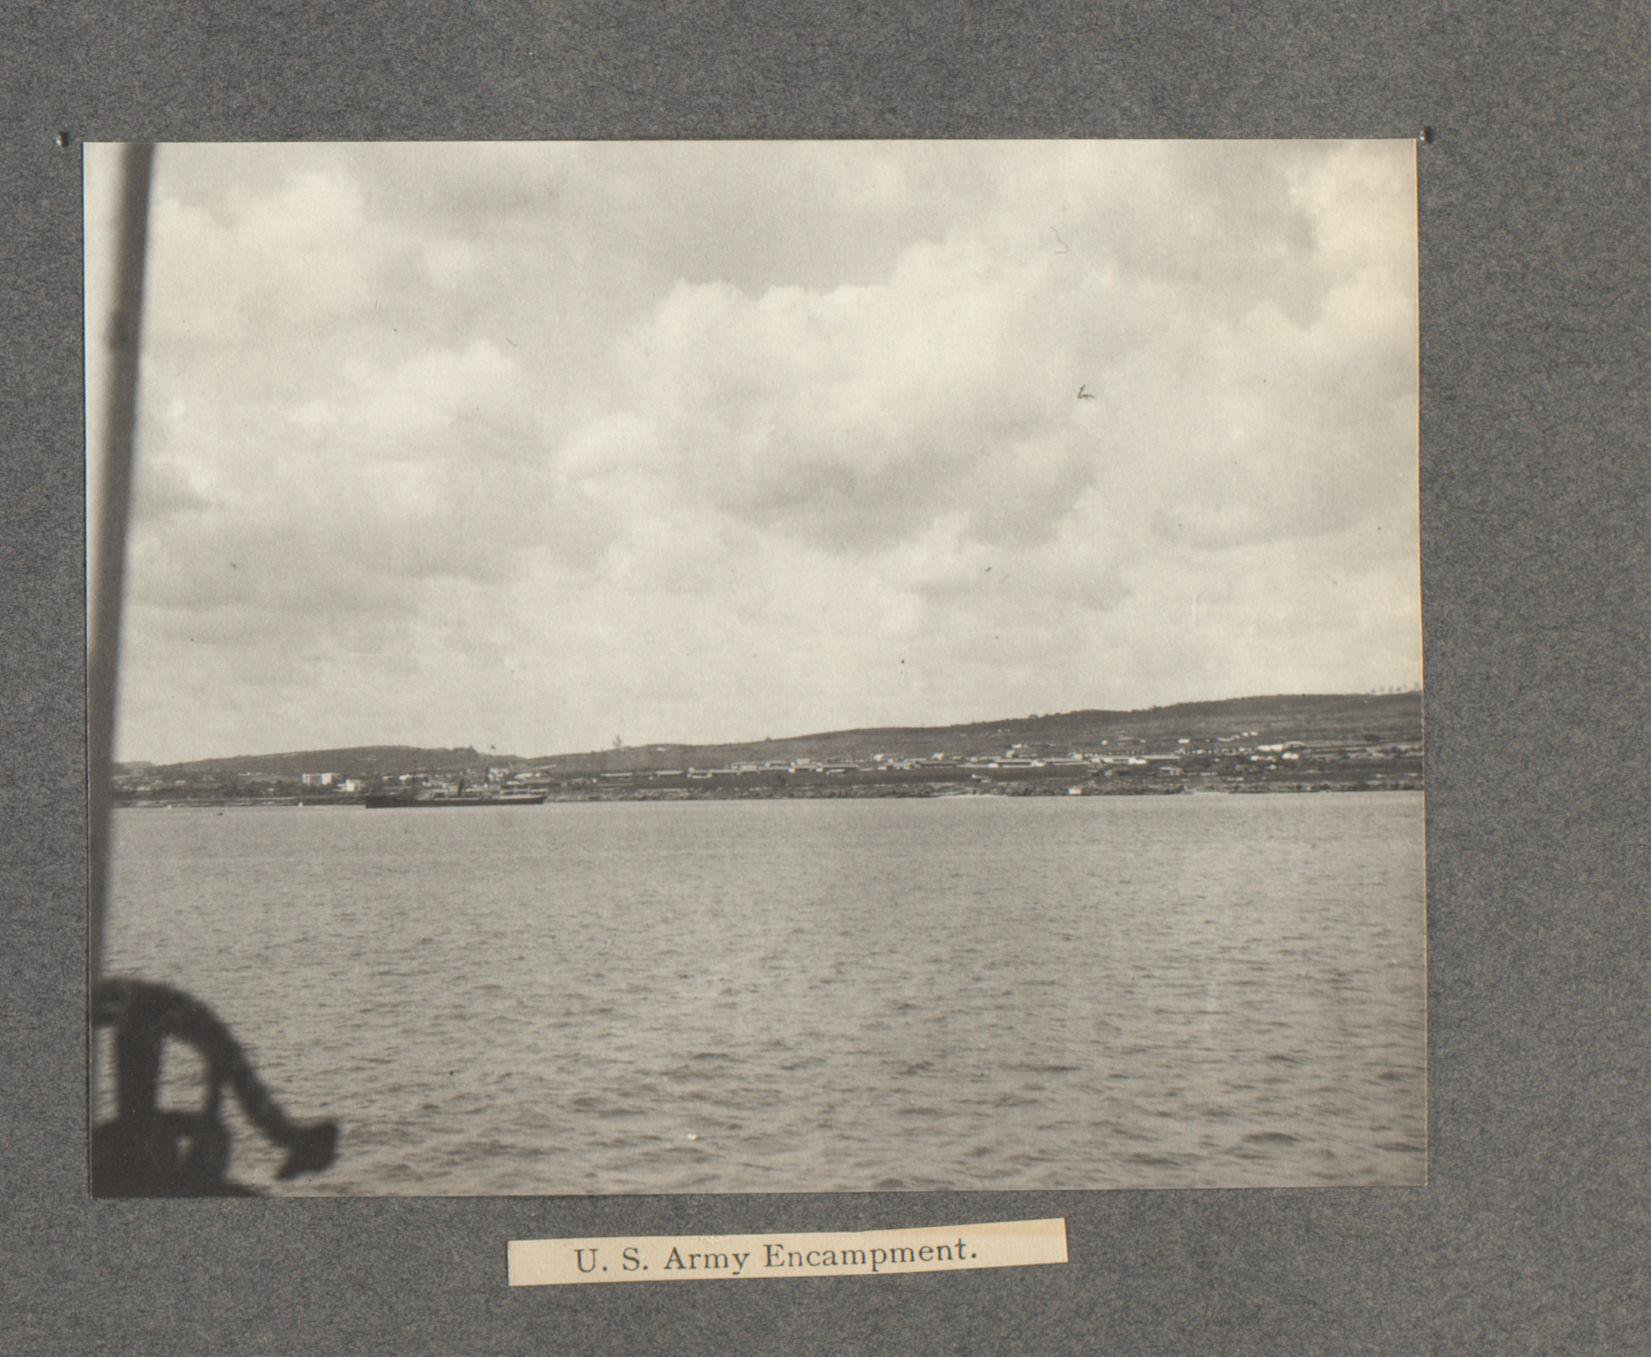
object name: photograph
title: Gezicht op een baai met een Amerikaanse legerbasis in de verte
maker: Anonymous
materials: paper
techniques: platinum process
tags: gulf, bay